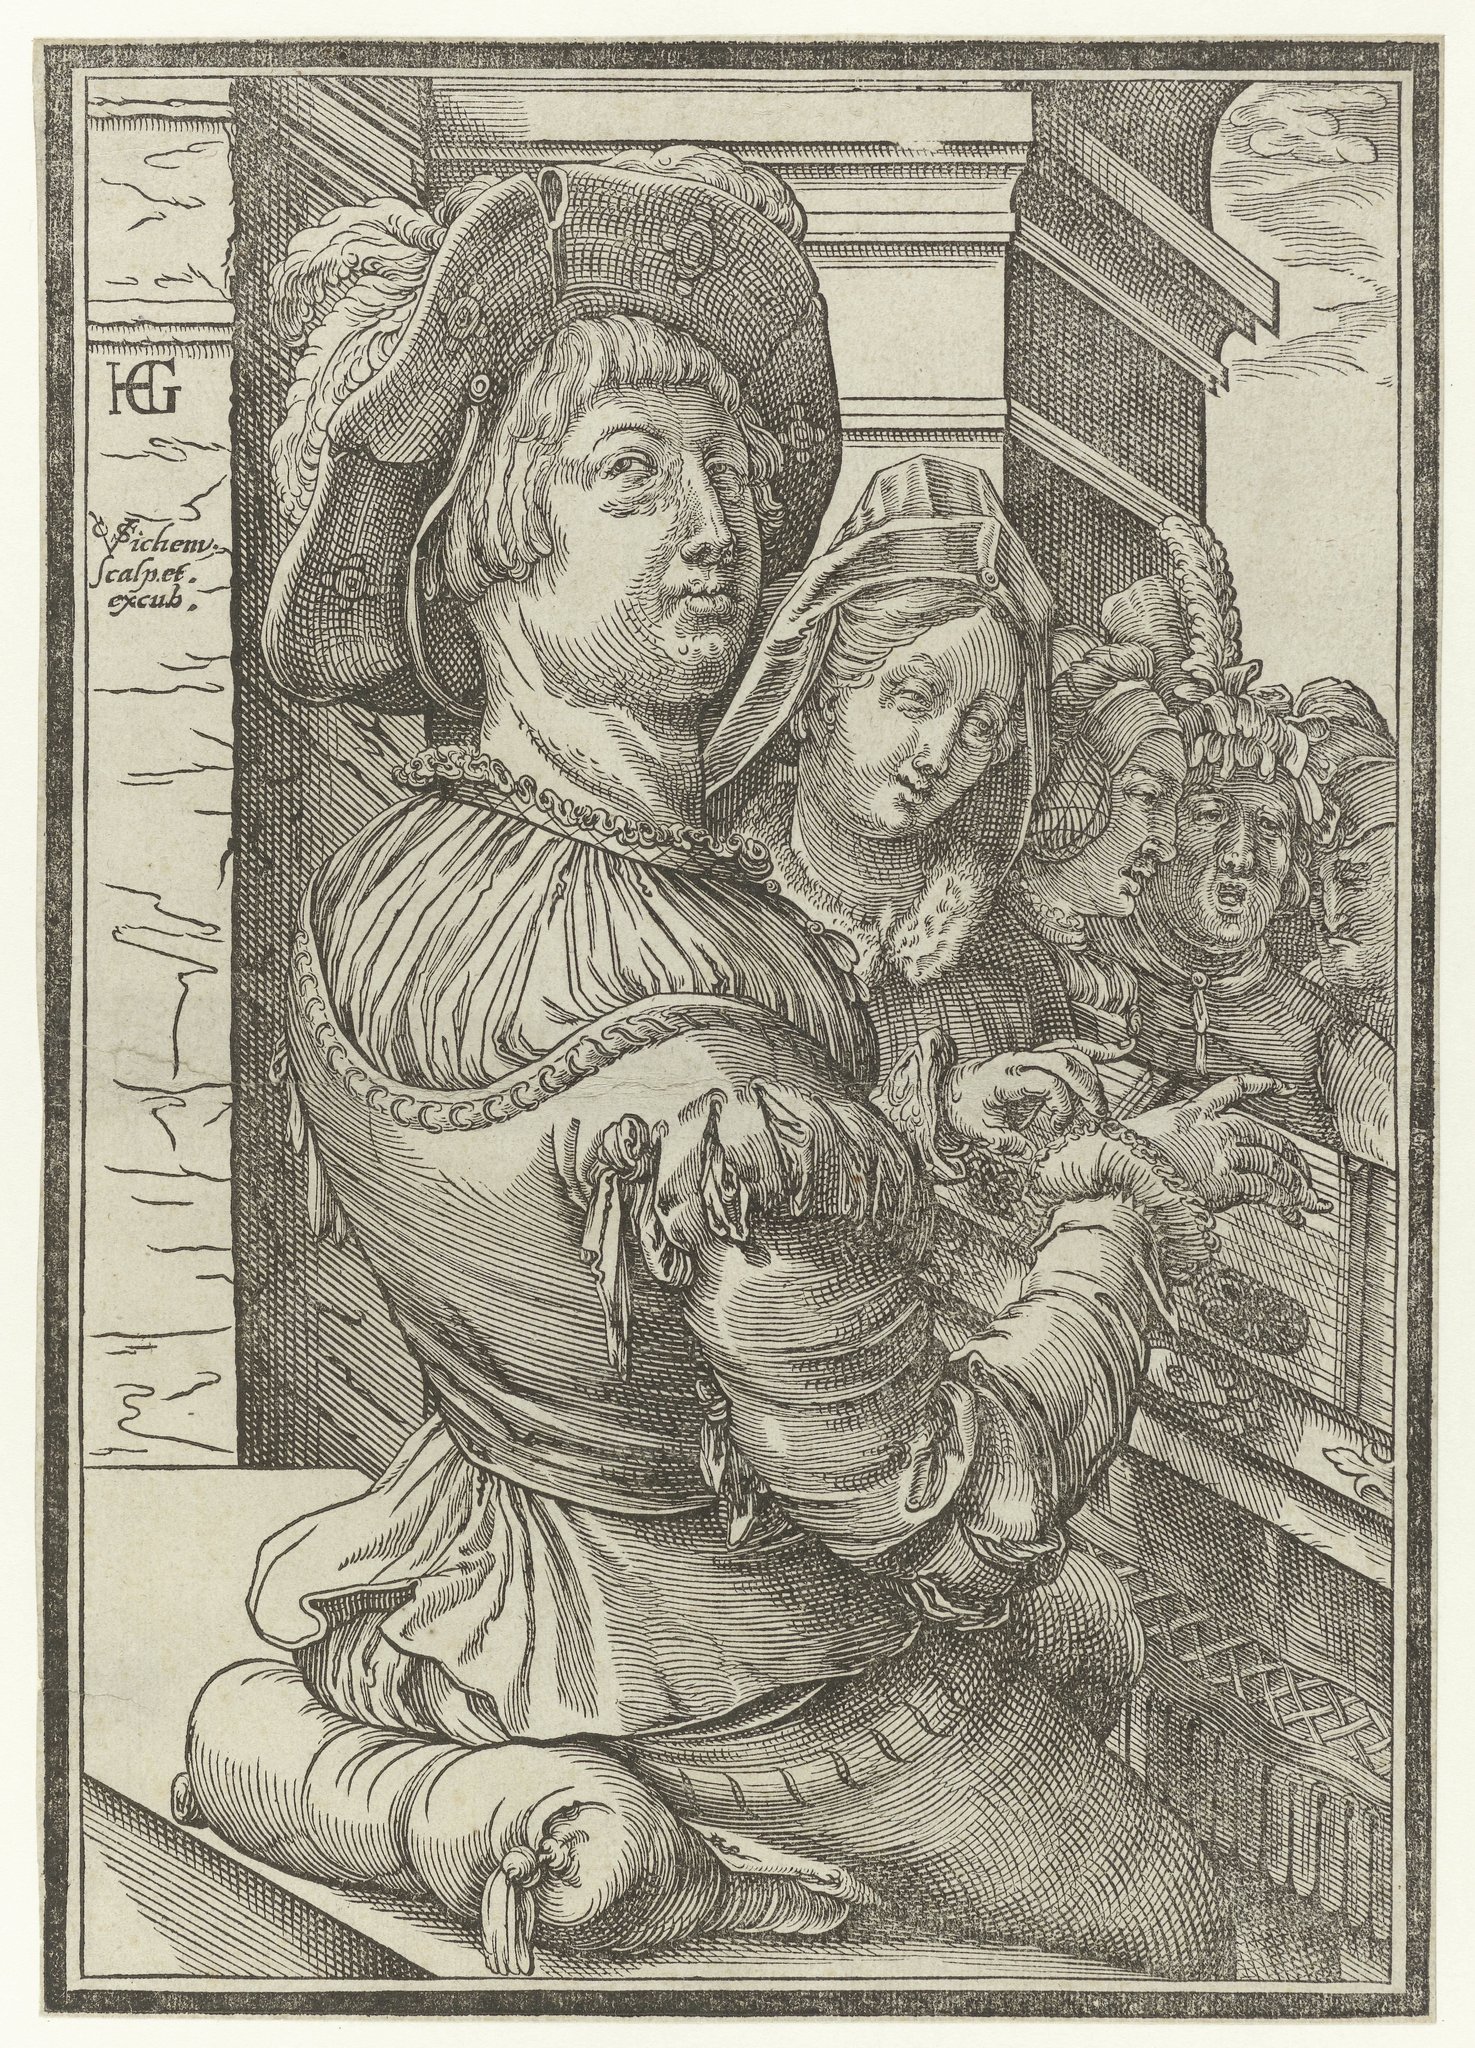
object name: print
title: Citerspelende jongeman met vier zingende figuren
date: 1546-1624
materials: paper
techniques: woodcut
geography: amsterdam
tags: male singer, musician(s) accompanying singer(s), female singer, dulcimer, zither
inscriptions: collector's mark: Lugt 1209, collector's mark: Lugt 2228, collector's mark: Lugt 2760